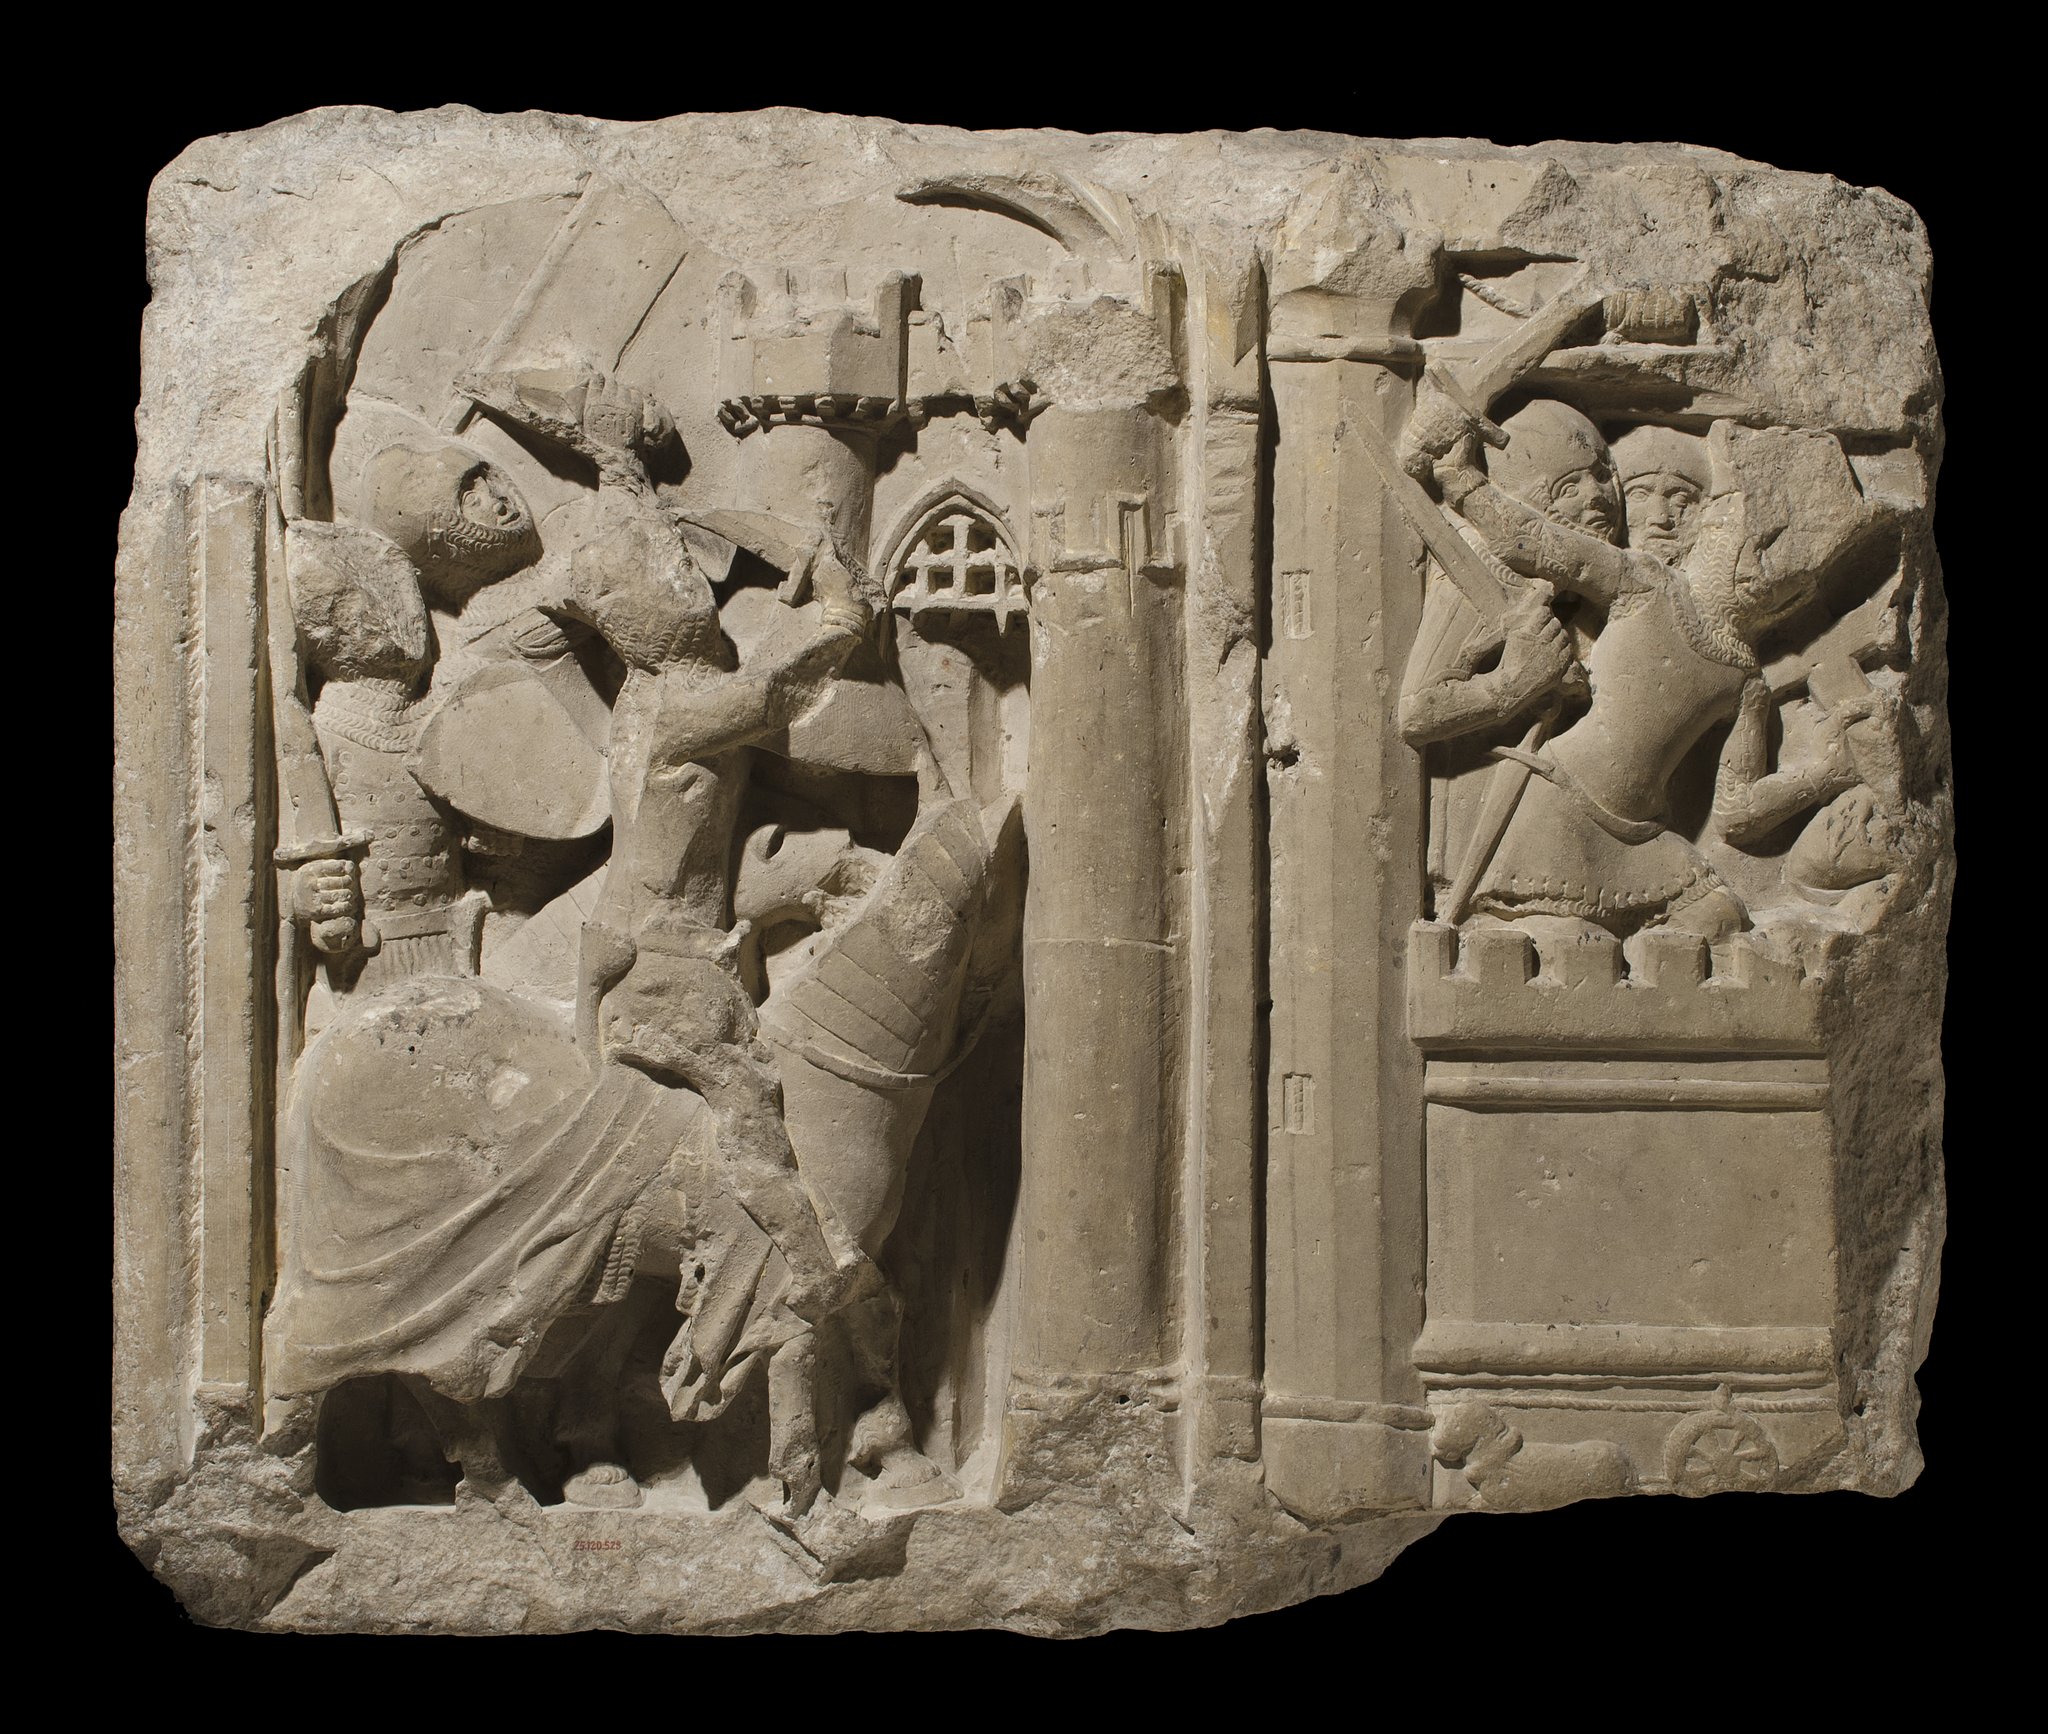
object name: relief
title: Scene from the Legend of the True Cross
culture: dutch or french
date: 1351-1400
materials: stone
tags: men,horses,knights